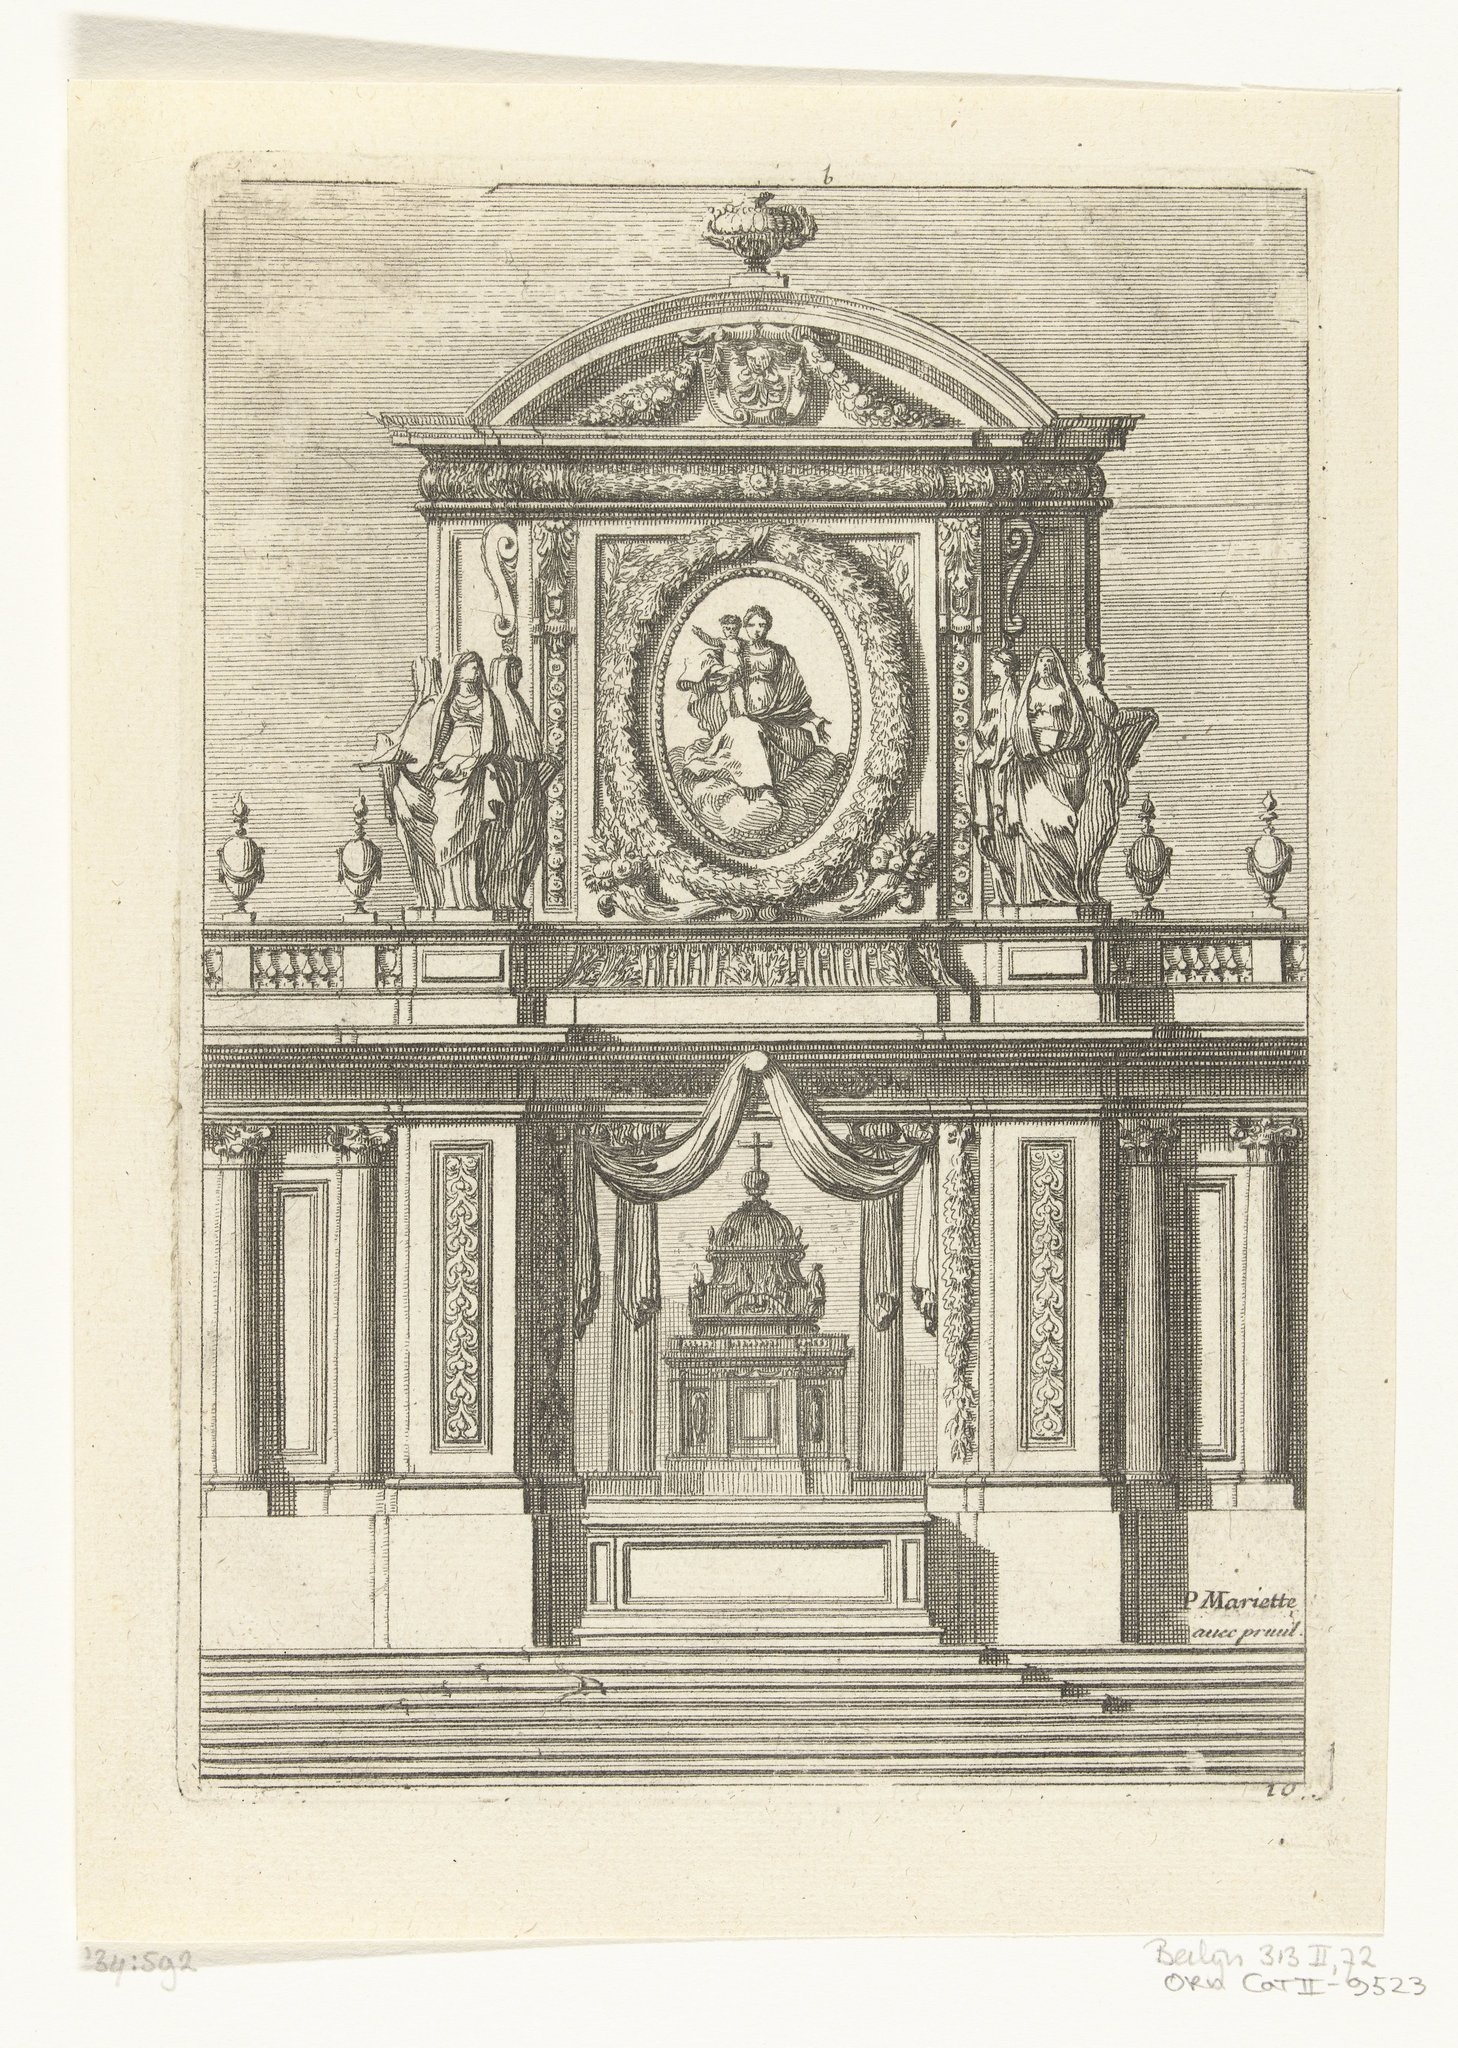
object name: print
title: Tabernakel met Heilige Maagd en Kind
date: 1666-1693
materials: paper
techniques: etching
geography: paris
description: Midden boven staat de letter b. Uit tweede editie van serie met altaren en tabernakels.